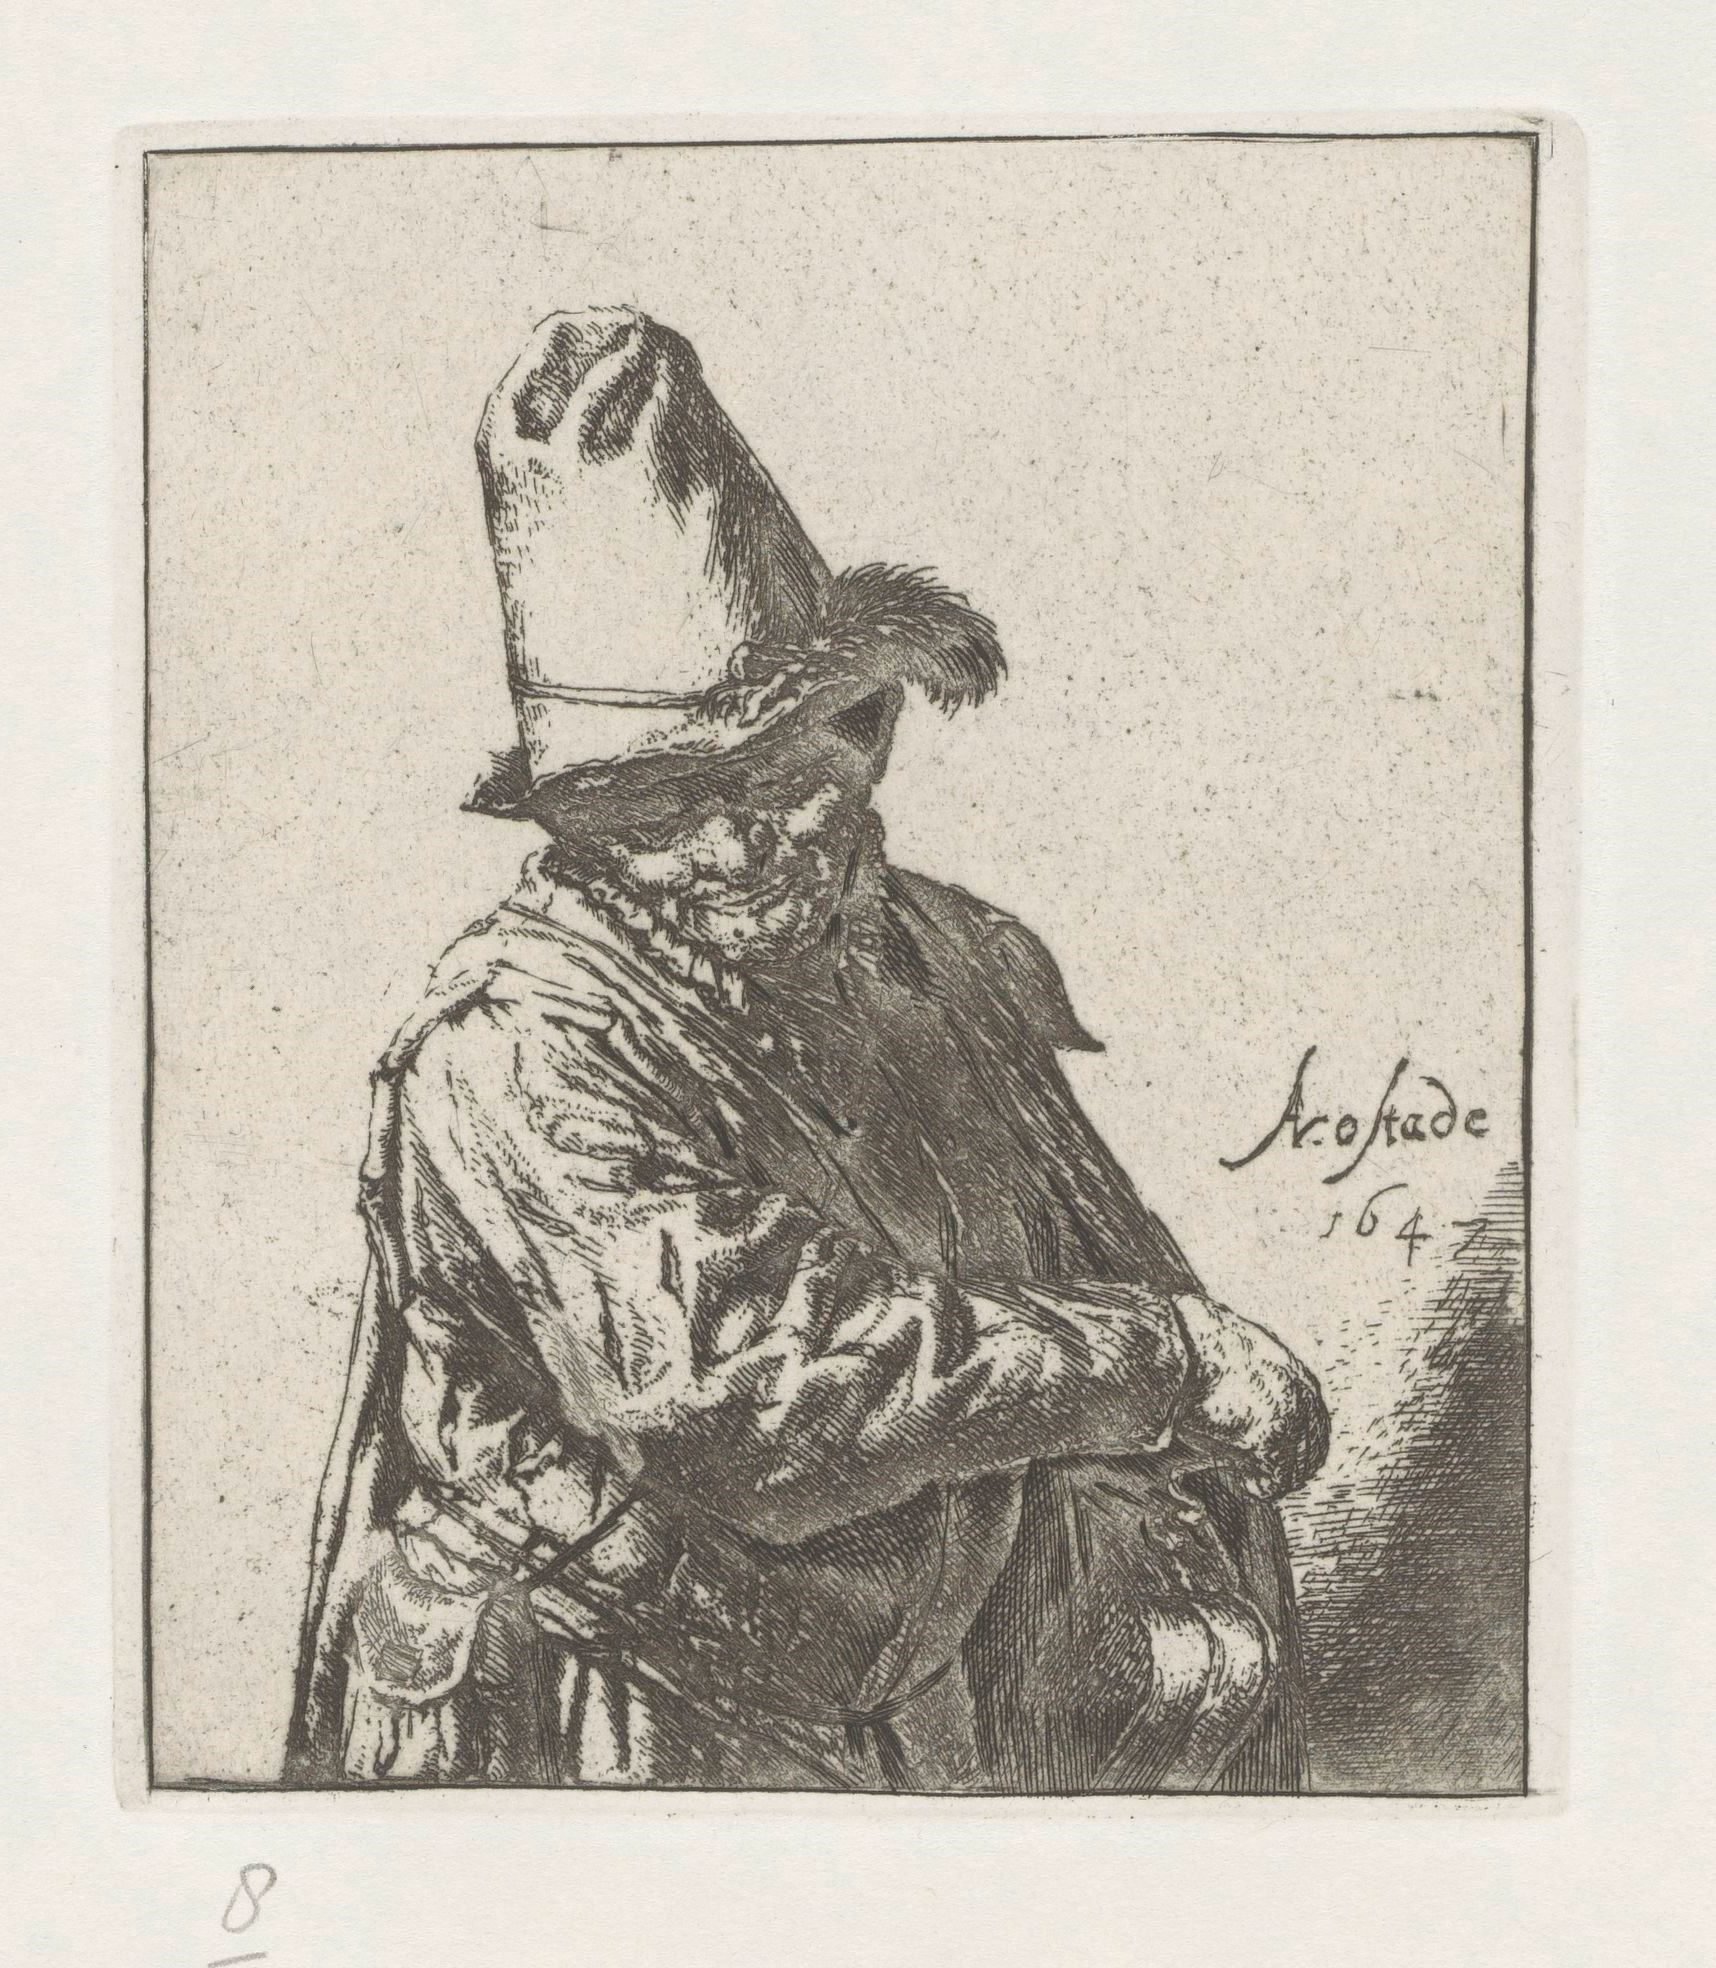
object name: album leaf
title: Lierdraaier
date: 1647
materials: paper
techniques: etching, galvanization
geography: haarlem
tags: hurdy-gurdy, hurdy-gurdy player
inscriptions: collector's mark: ‘RIJKS / MUSM’, collector's mark: ‘B’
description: De prent maakt deel uit van een portefeuille en is met een andere prent op één albumblad gedrukt.